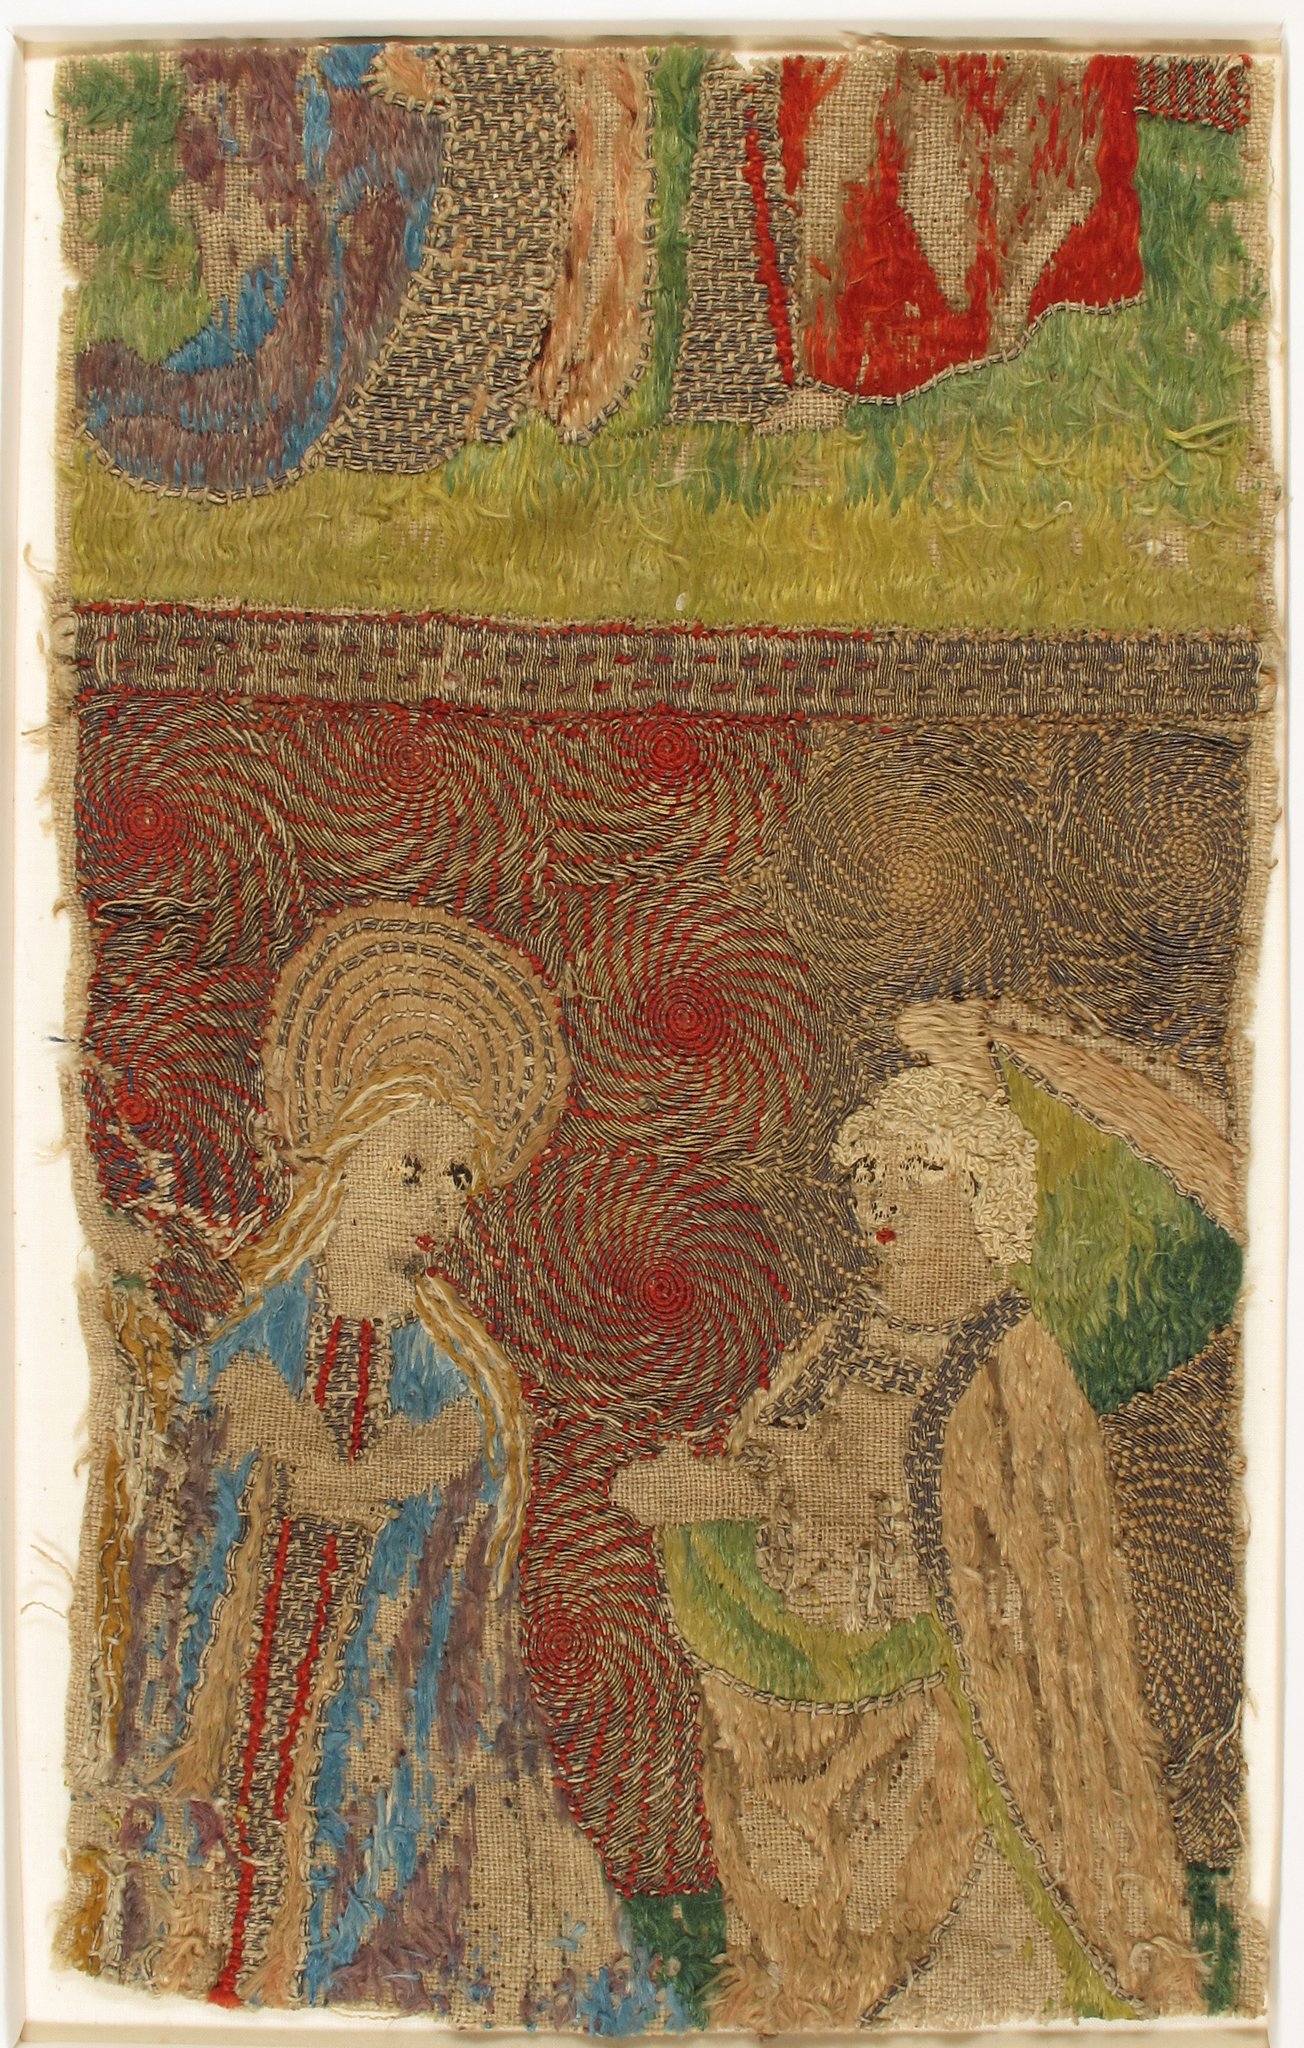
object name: panel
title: Panel with the Virgin and Gabriel Annunciate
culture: german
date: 1401-1500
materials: linen, silk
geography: germany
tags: archangel gabriel